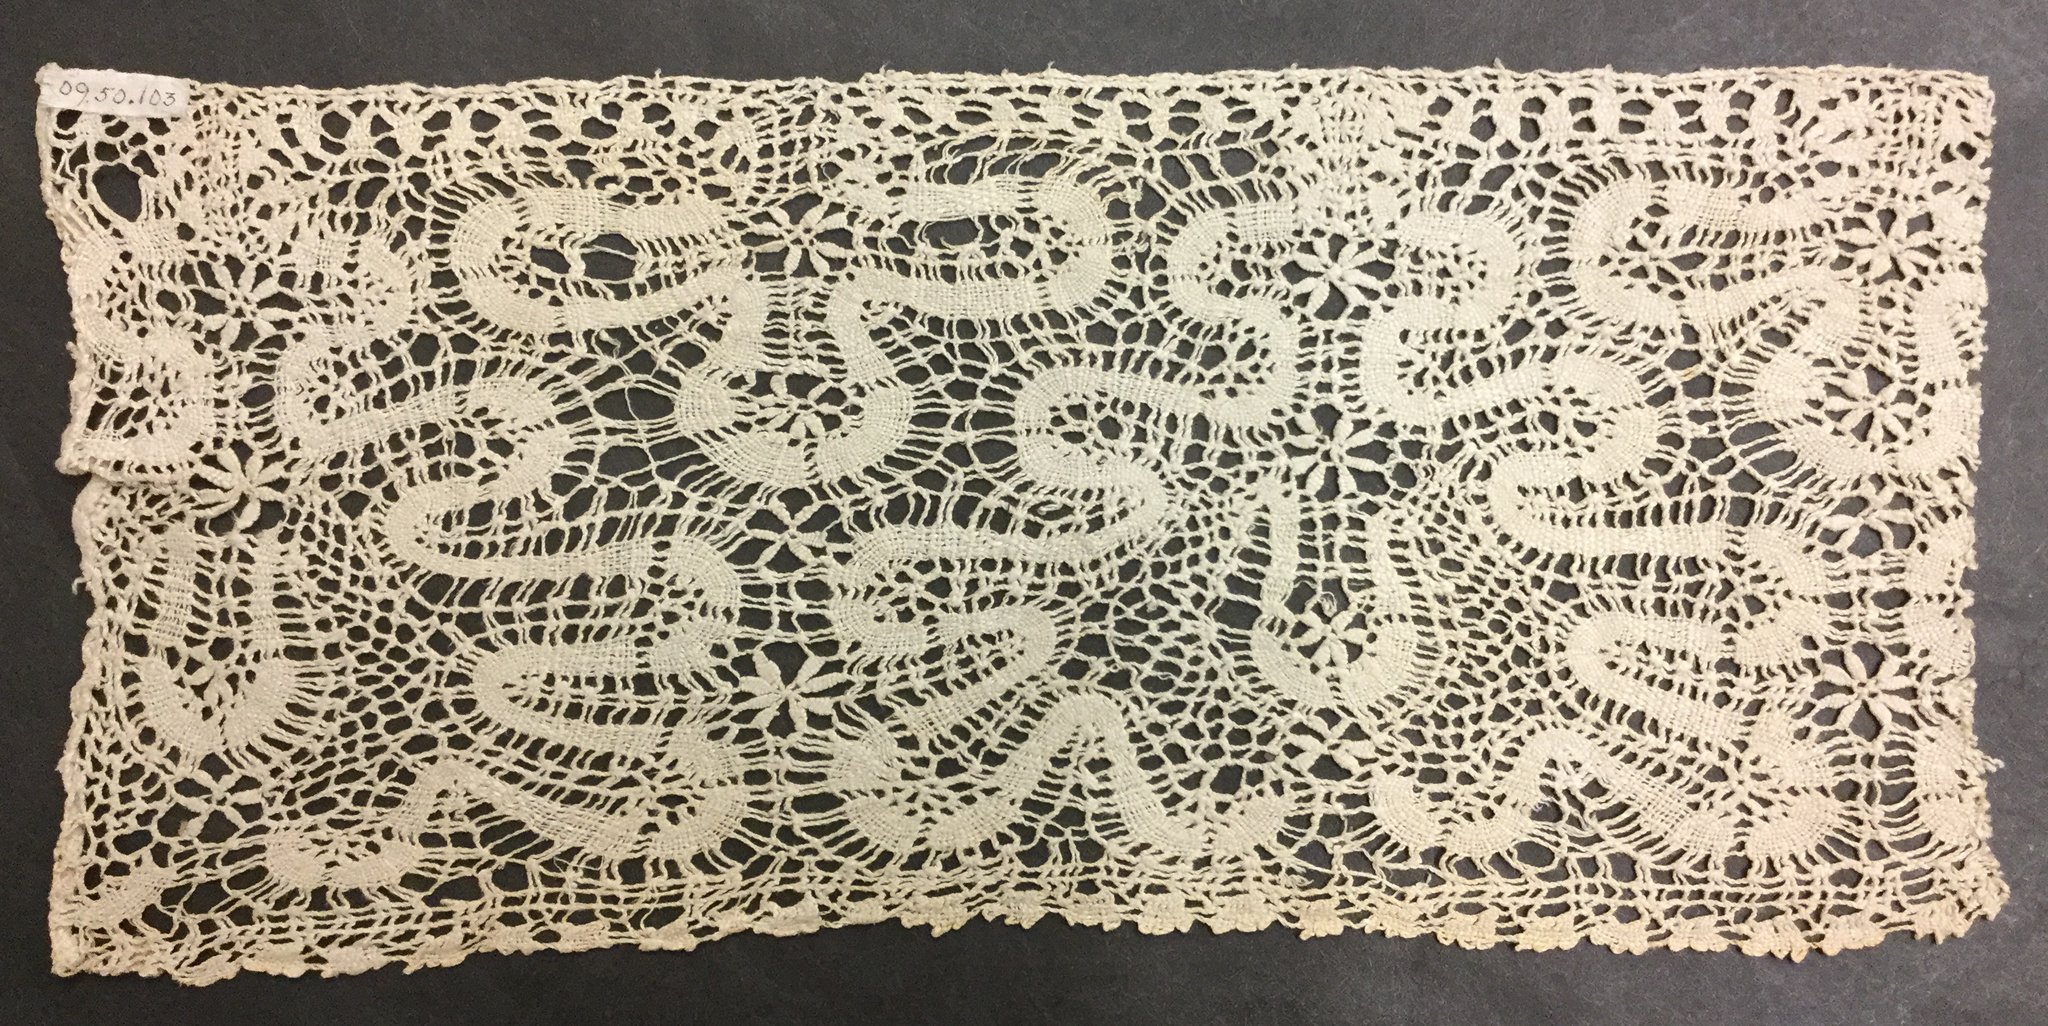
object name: fragment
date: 1701-1800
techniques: lace